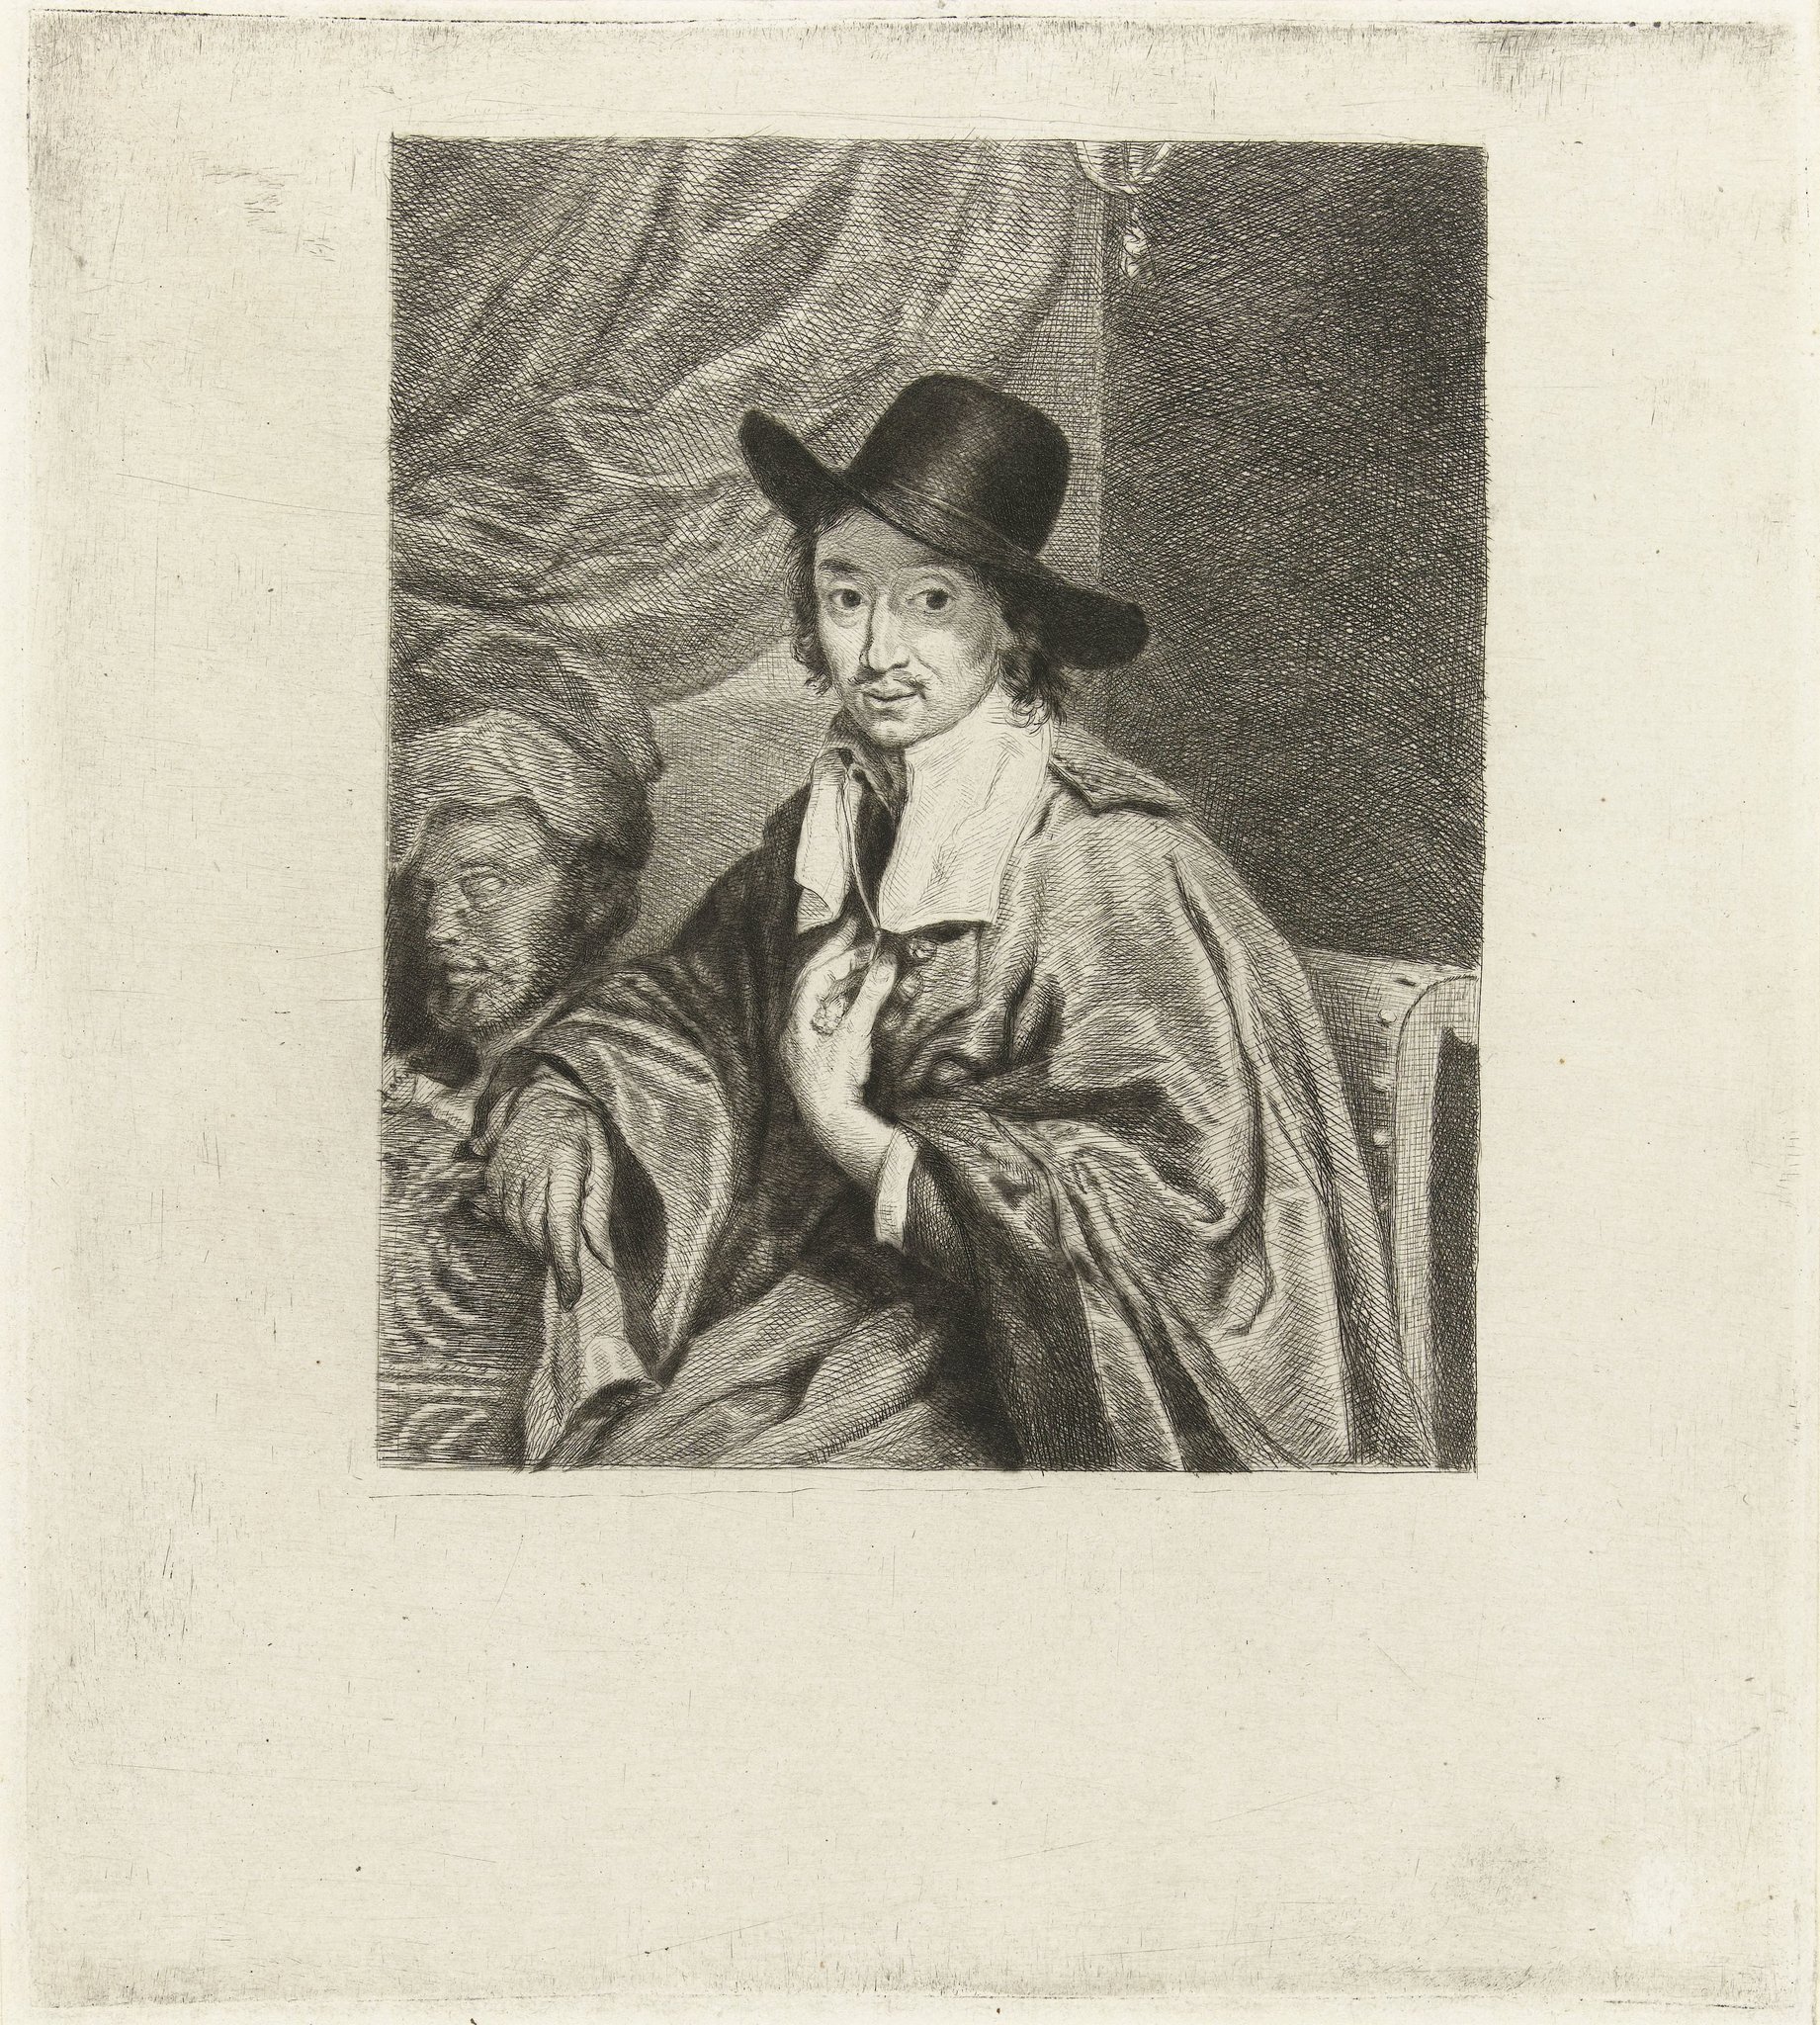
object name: print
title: Portret van de schilder Adriaen van Ostade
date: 1756-1817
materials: paper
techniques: drypoint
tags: haarlem, painter, print maker, draughtsman, adriaen van ostade, portrait, self-portrait of artist (+ artist in non-work situation)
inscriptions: collector's mark: Lugt 2228